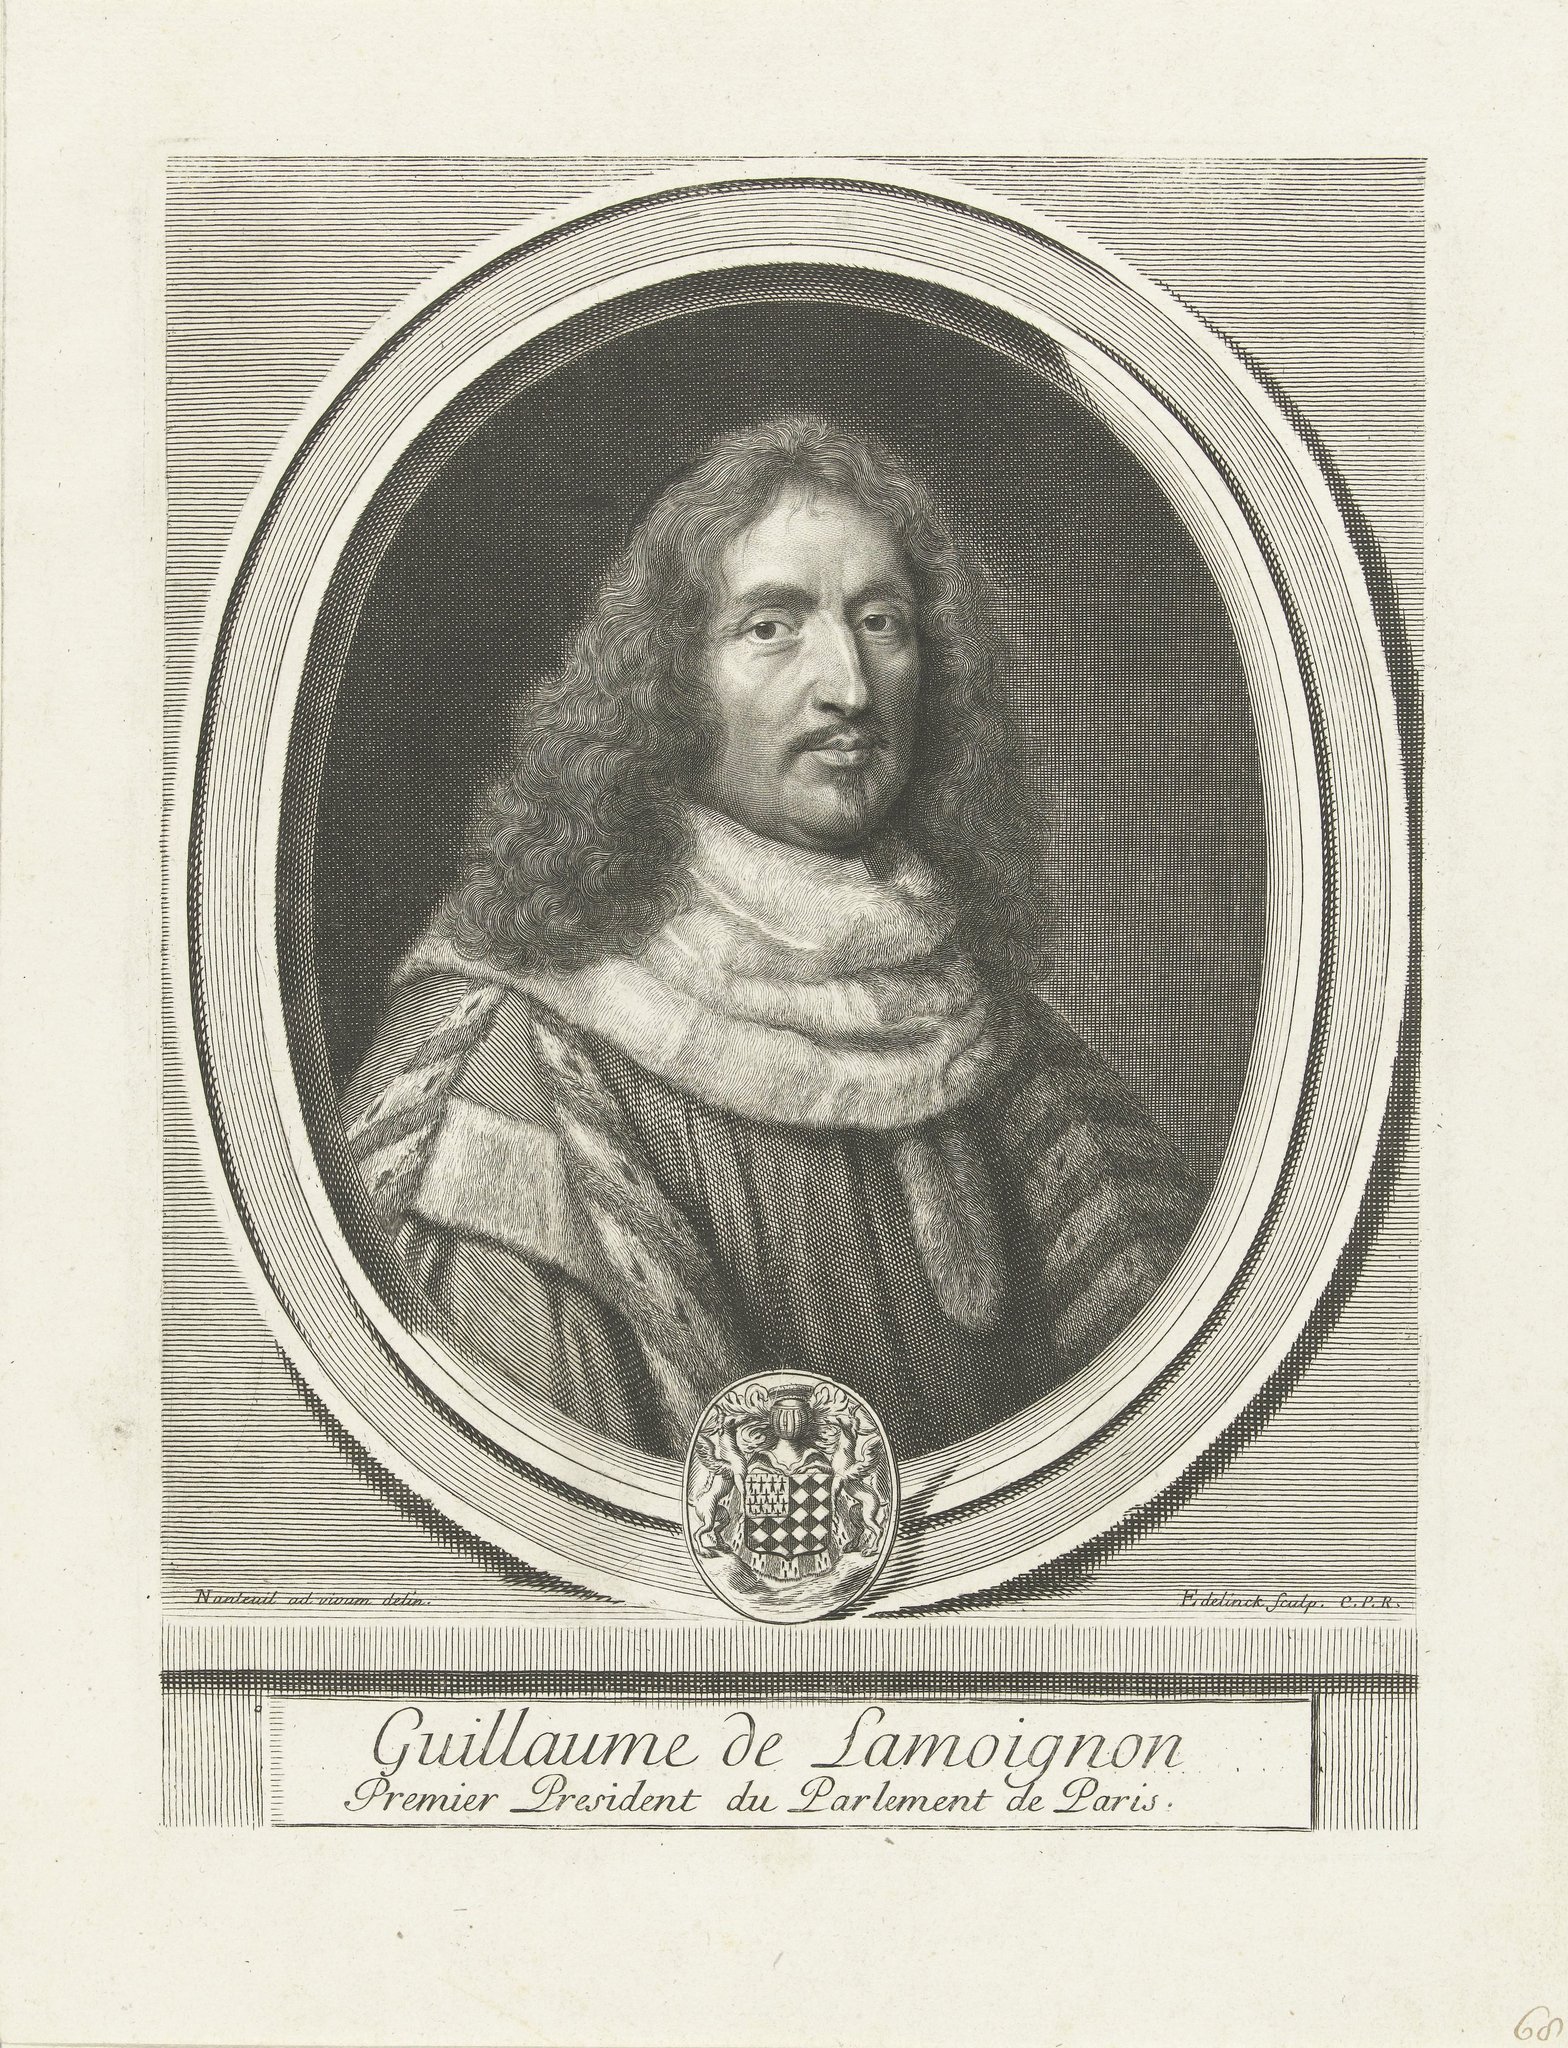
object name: print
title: Portret van Guillaume de Lamoignon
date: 1666-1707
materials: paper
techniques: engraving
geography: paris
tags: paris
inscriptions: collector's mark: Lugt 240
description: Portret van de Franse jurist Guillaume de Lamoignon (1617-1677) in bontmantel, afgebeeld in ovale omlijsting met wapen.